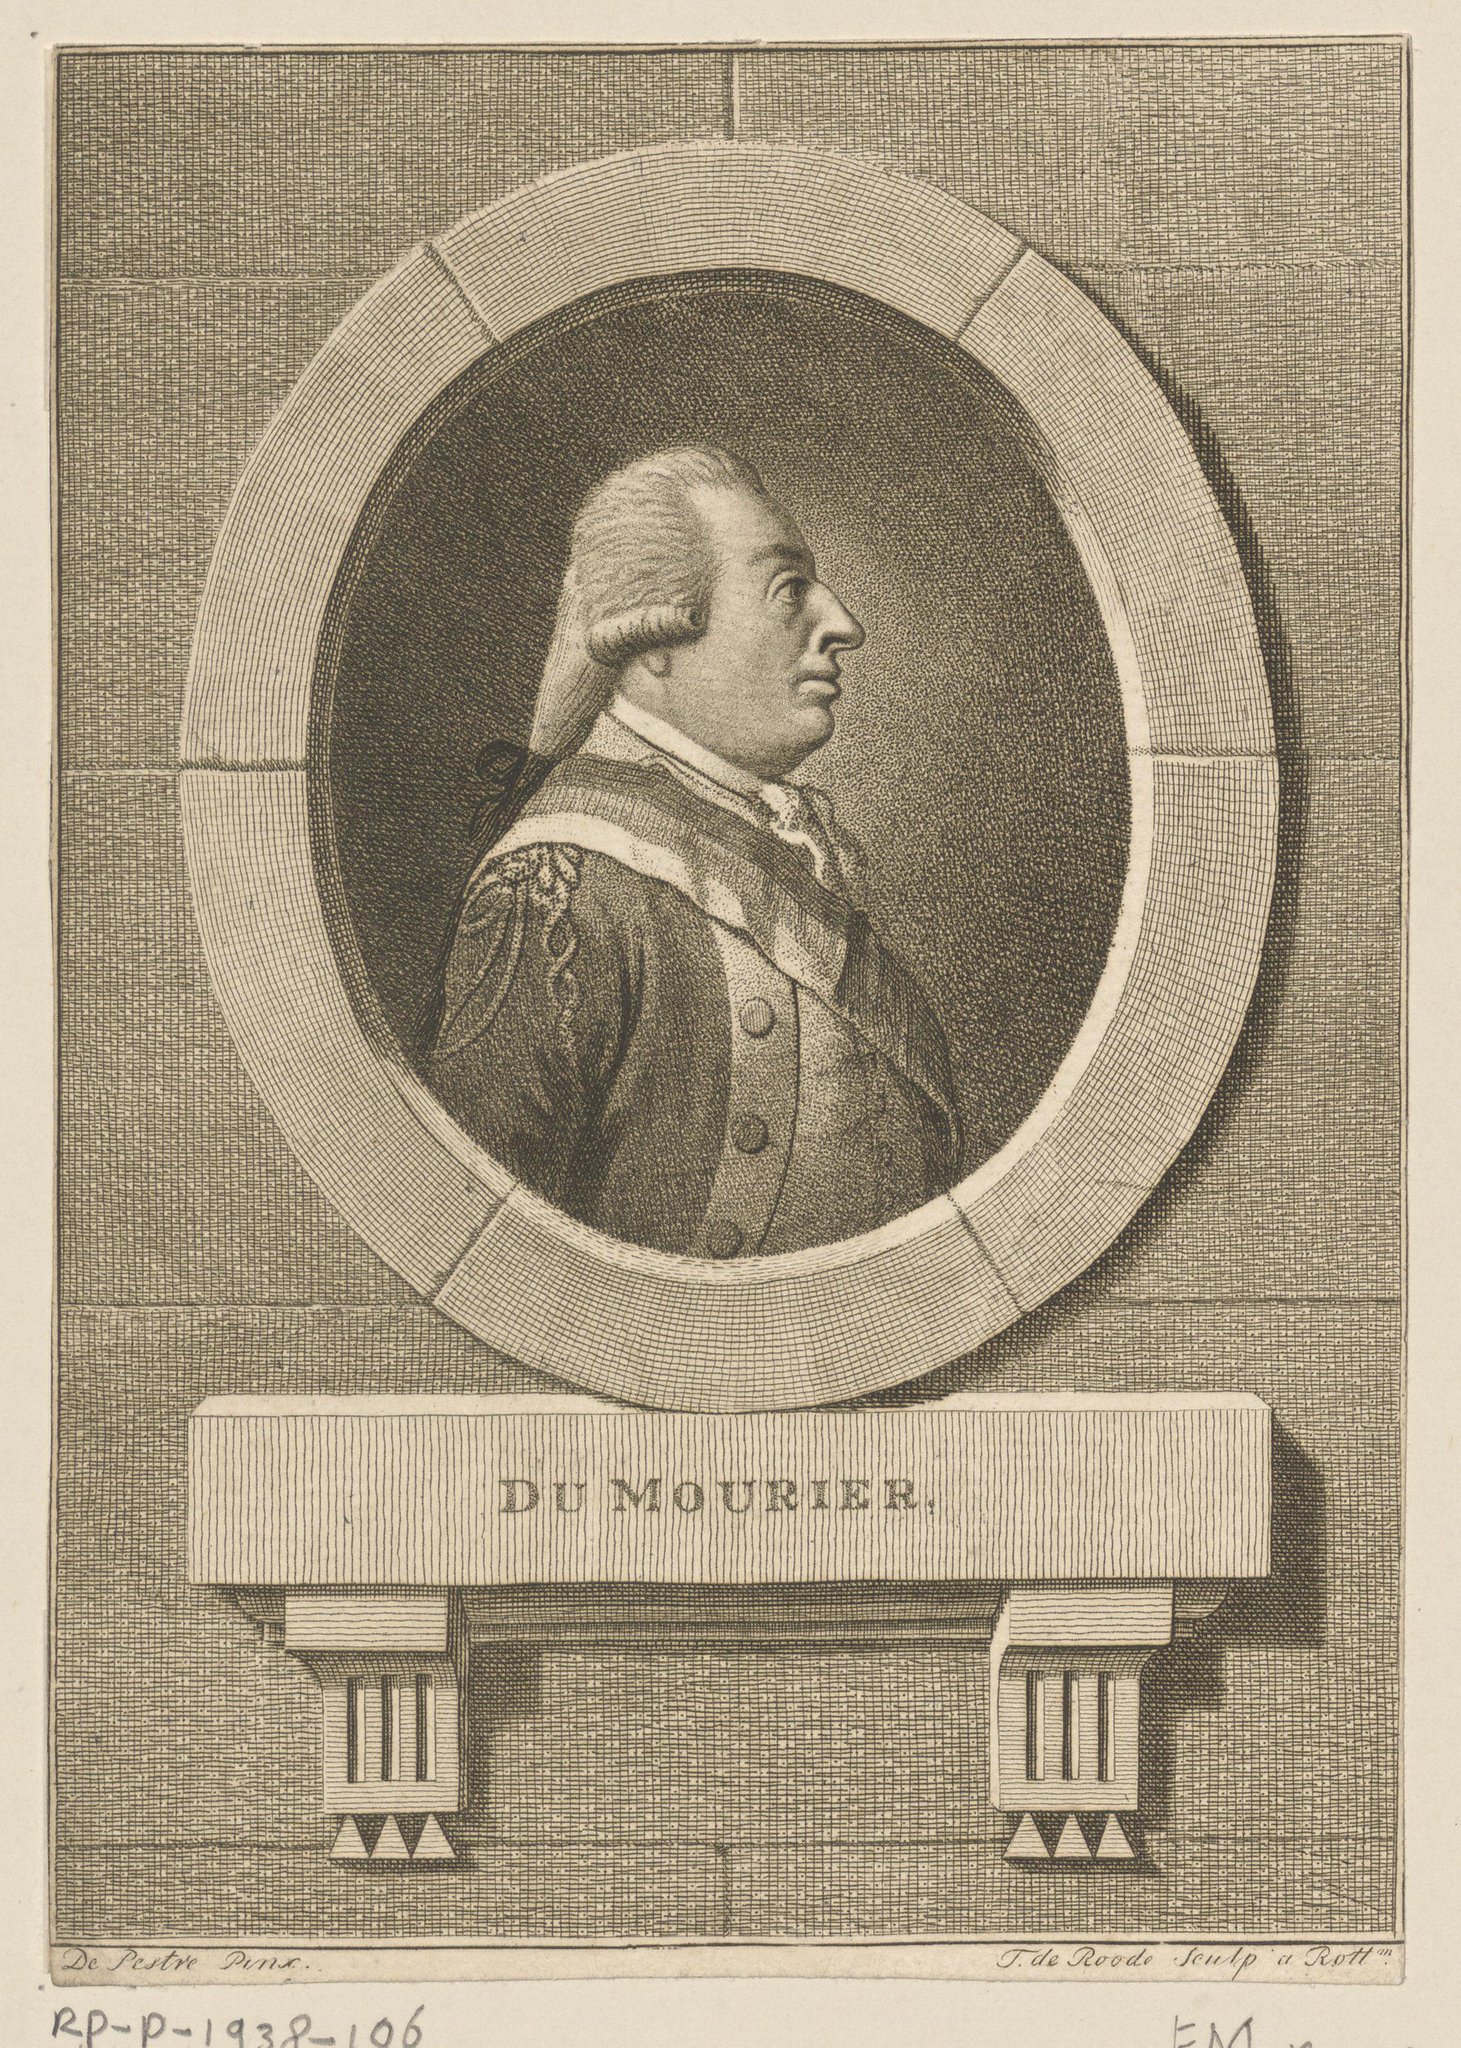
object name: print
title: Portret van Charles François Dumouriez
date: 1751-1853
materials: paper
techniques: engraving, etching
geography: rotterdam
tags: commander-in-chief, general, marshal, historical persons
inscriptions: collector's mark: Lugt 2228